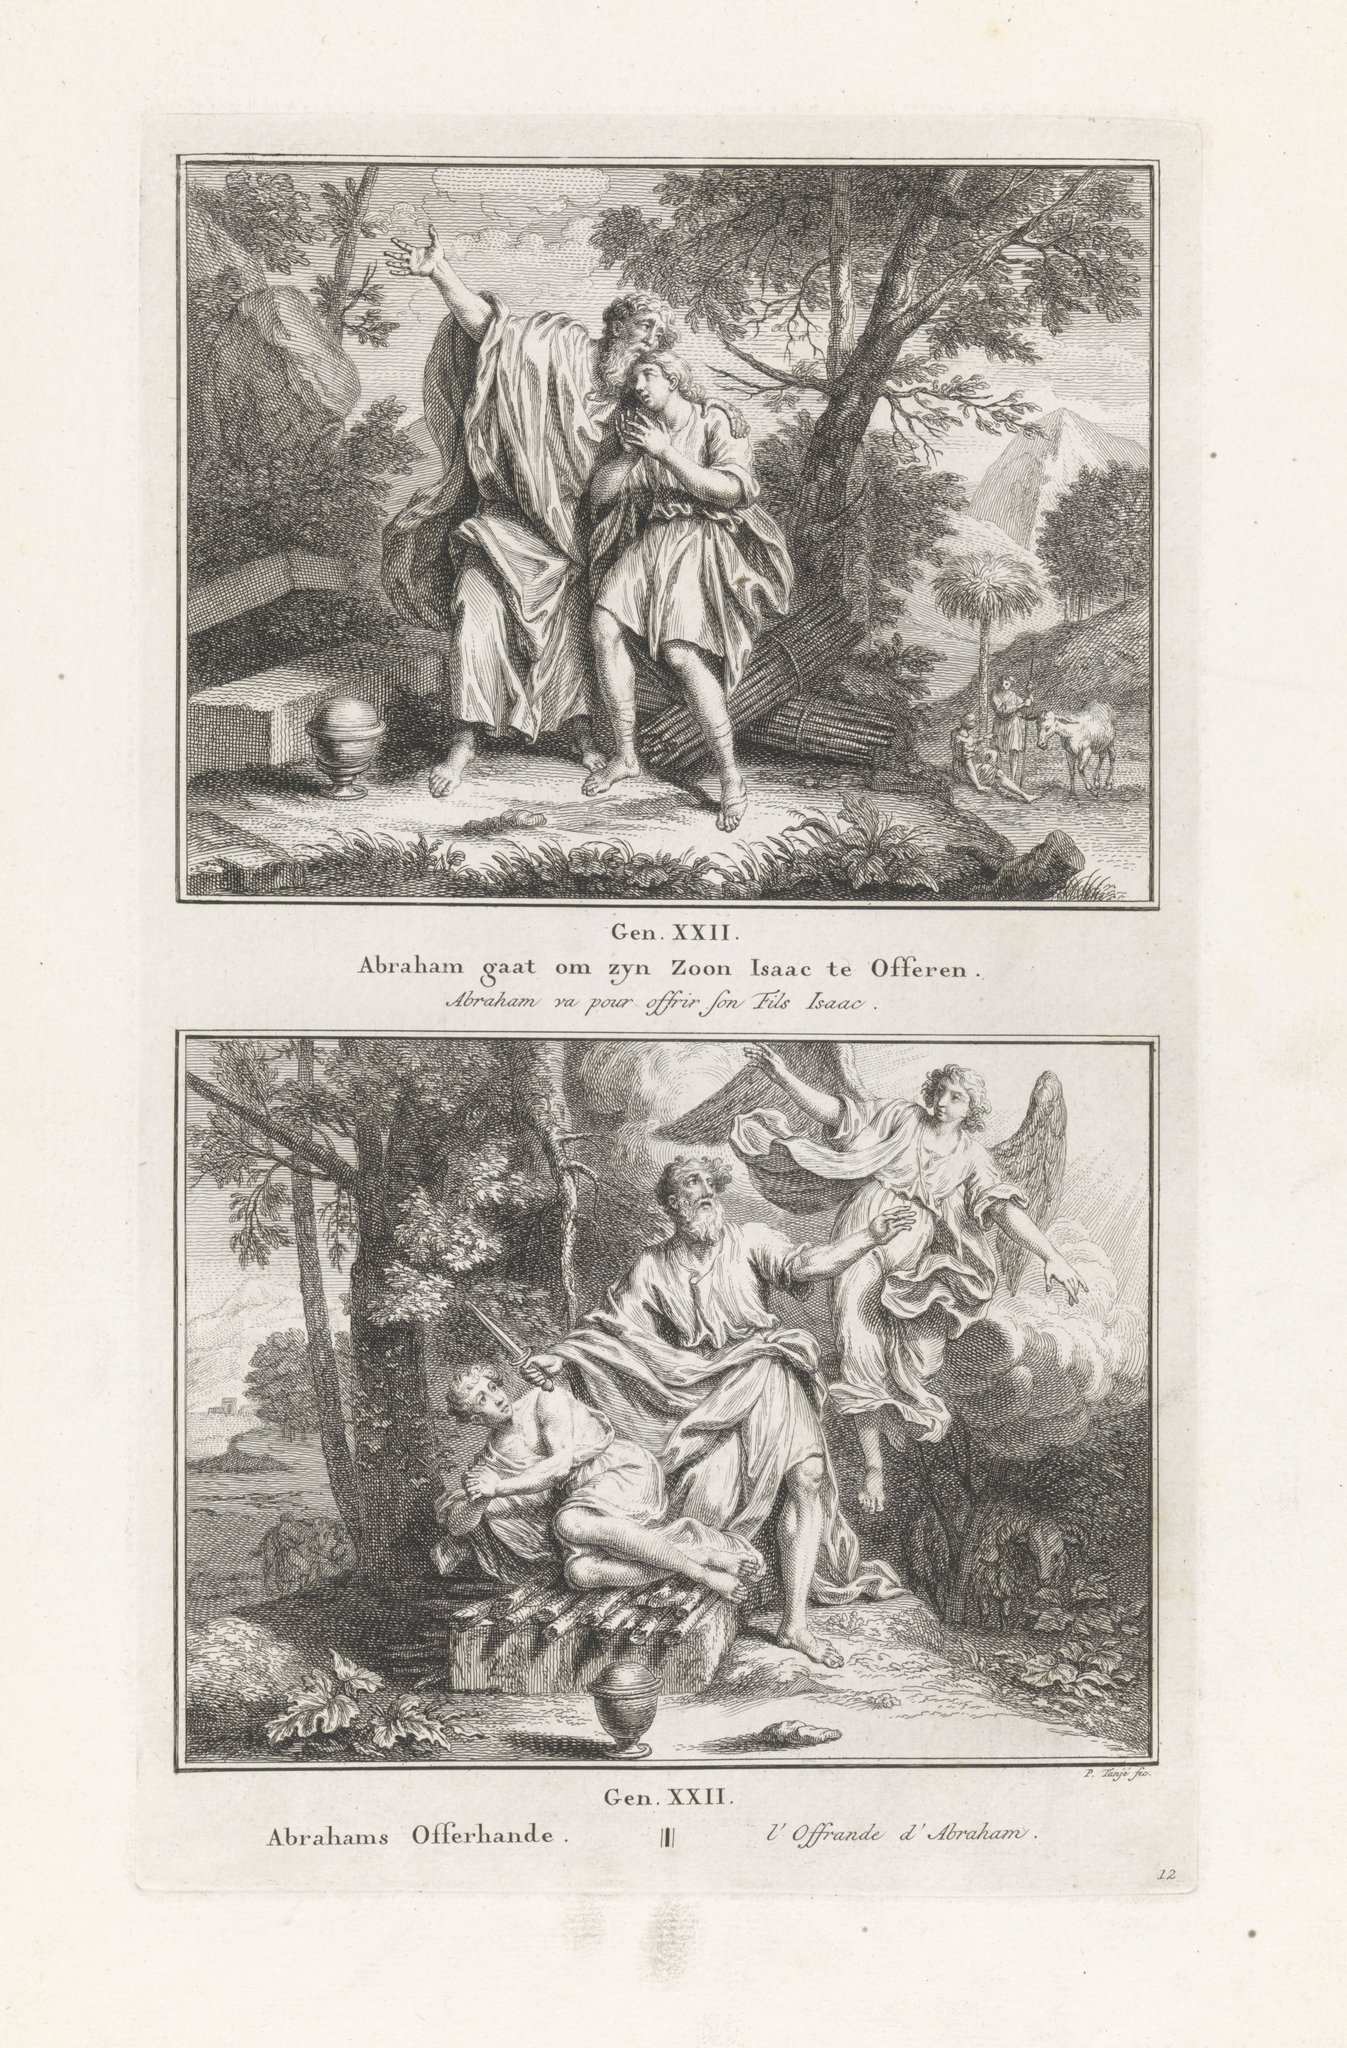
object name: book illustration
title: Abraham en Isaak op weg naar de offerplaats / Offer van Isaak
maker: pieter tanjé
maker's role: draughtsman, print maker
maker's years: 1706-1761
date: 1716-1761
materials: paper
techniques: engraving, etching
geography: amsterdam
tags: the servants are left behind while abraham and isaac (usually carrying wood) climb the mountain, when abraham has his hand raised to kill isaac, an angel restrains abraham's hand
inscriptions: collector's mark: Lugt 3937, collector's mark: Lugt 2233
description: Twee Bijbelse voorstellingen. Boven: Abraham en Isaak op weg naar de offerplaats. Zij hebben de knechten en ezel achter zich gelaten. Achter Isaak liggen twee houtbundels. Onder: Abraham, met een mes in de hand, staat op het punt zijn zoon Isaak te offeren, maar een engel weerhoudt hem daarvan. Rechts een ram in de struiken, die in Isaaks plaats zal worden geofferd. Onder de voorstellingen een verwijzing naar de Bijbelteksten en de titels in het Nederlands en Frans.